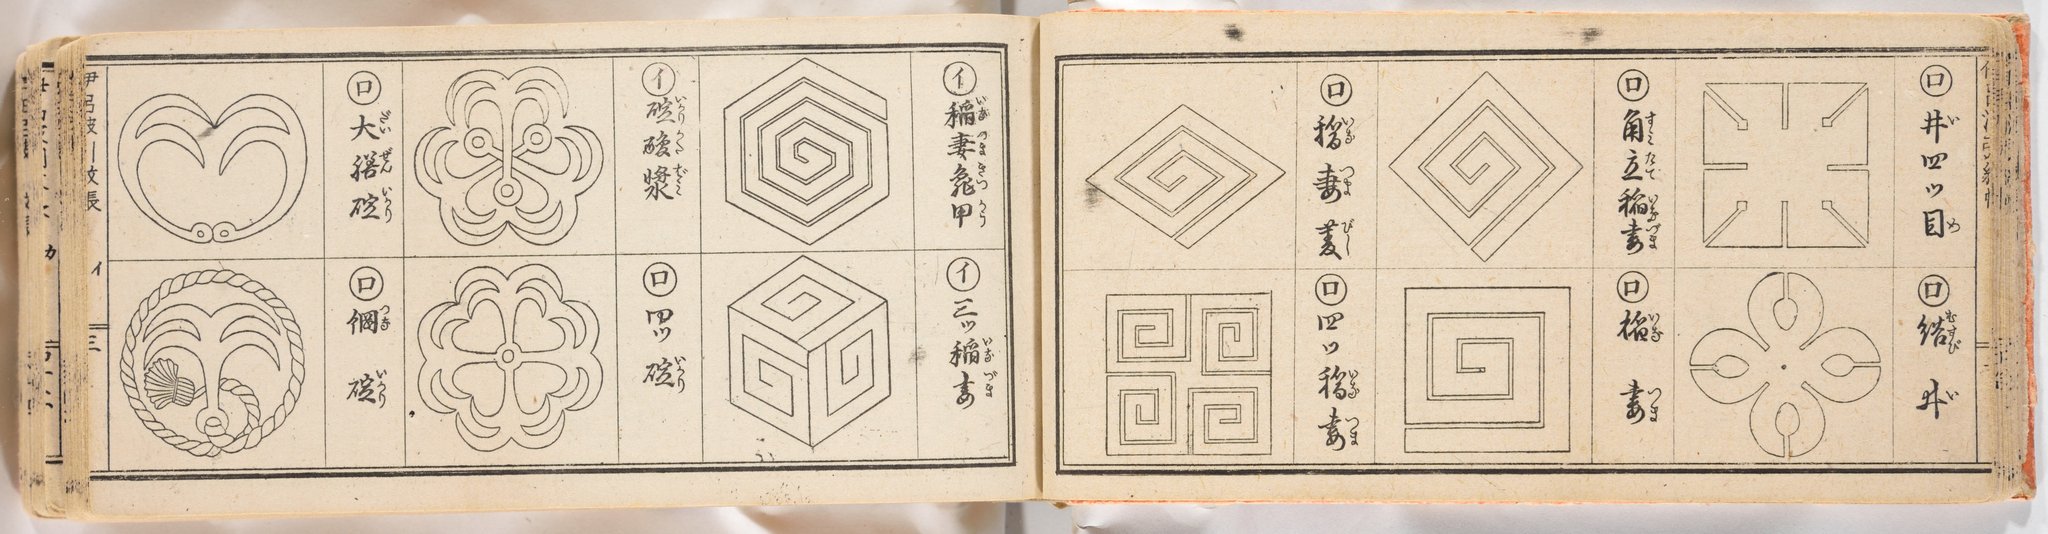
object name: illustrated book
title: A Notebook of Mon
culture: japanese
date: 1881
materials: ink, paper